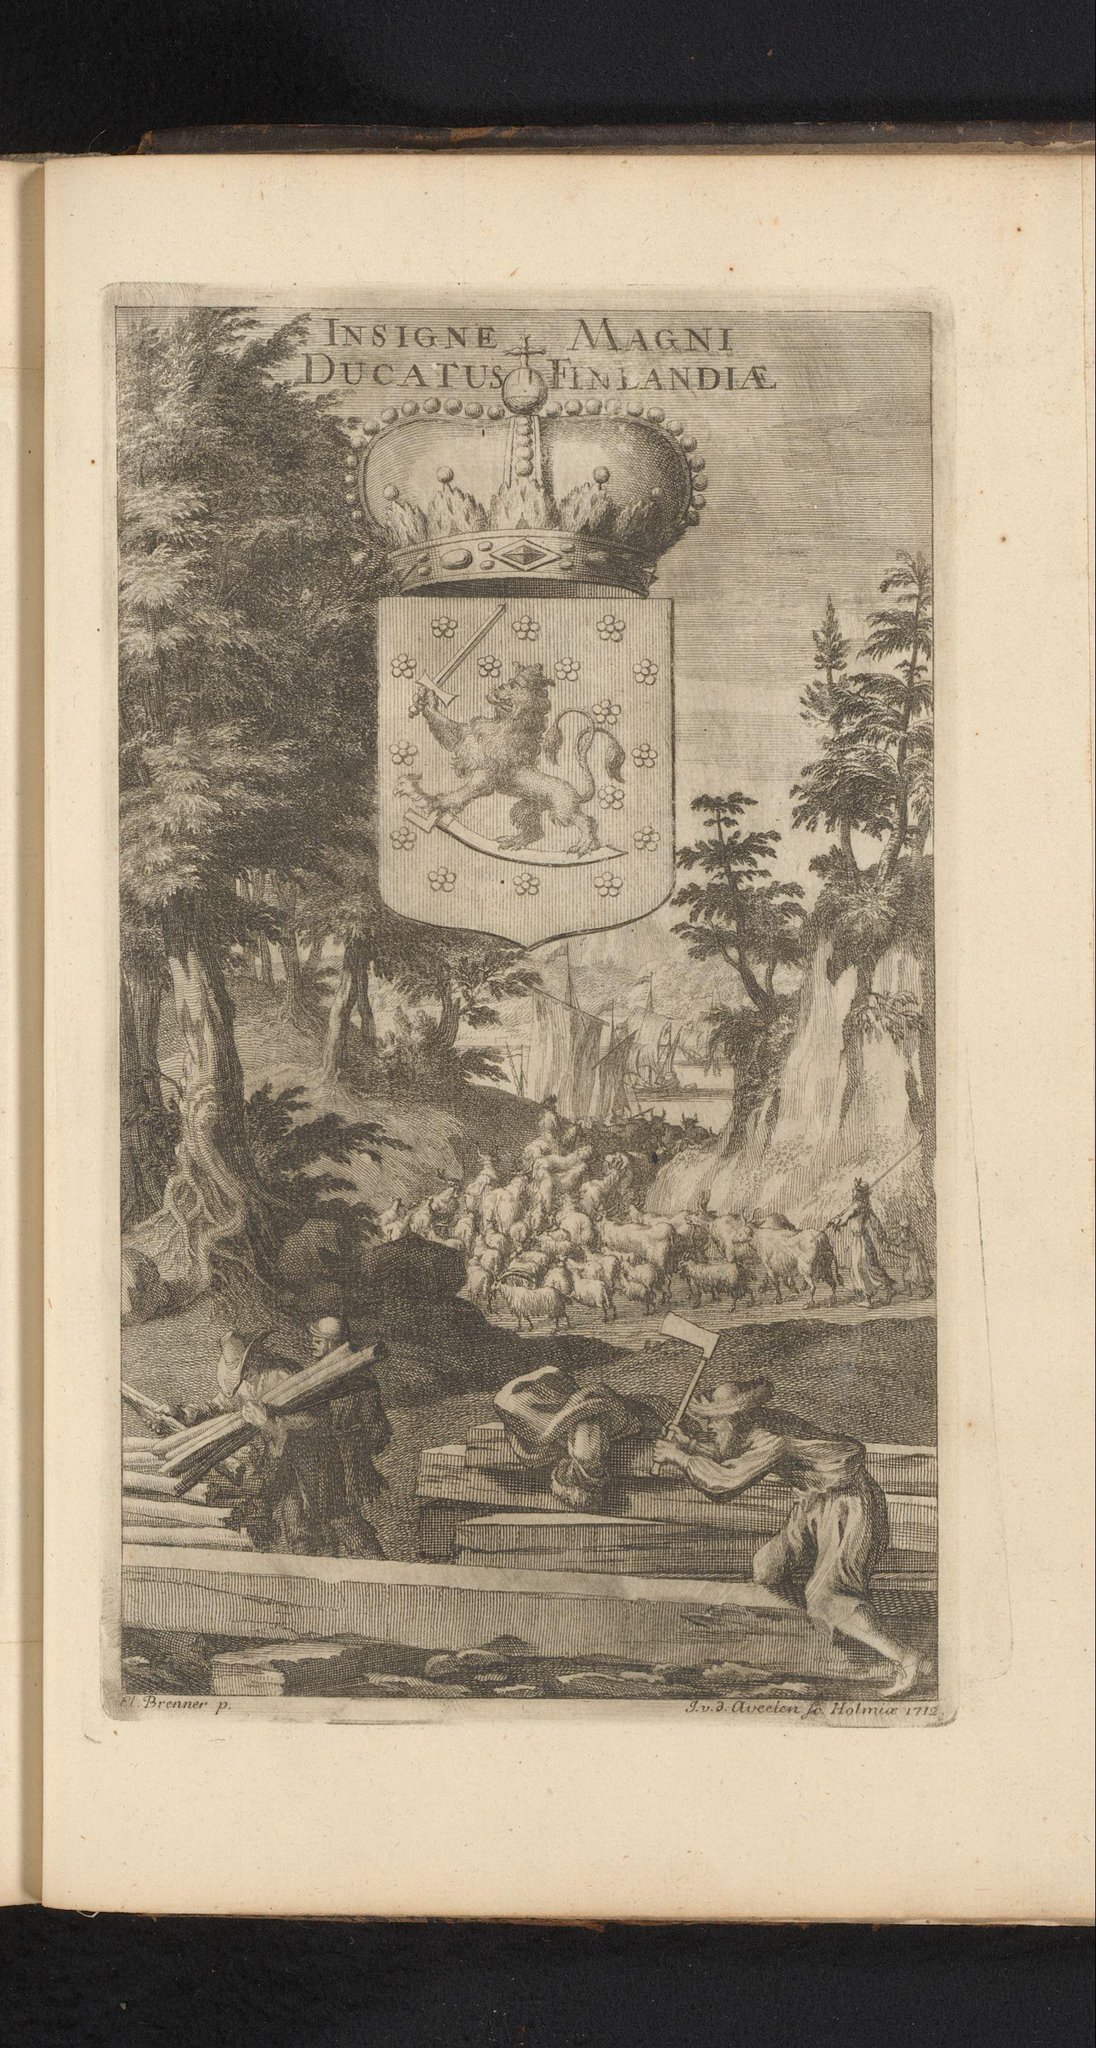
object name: album leaf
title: Landschap met houthakkers en het wapen van Groothertogdom Finland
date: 1712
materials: paper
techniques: etching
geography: stockholm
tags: coat of arms (as symbol of the state, etc.), landscapes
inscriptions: date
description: Kungliga Biblioteket, 'Suecia': http://www.kb.se/samlingarna/Kartor-bilder/Suecia-antiqua/ (geraadpleegd november 2016).